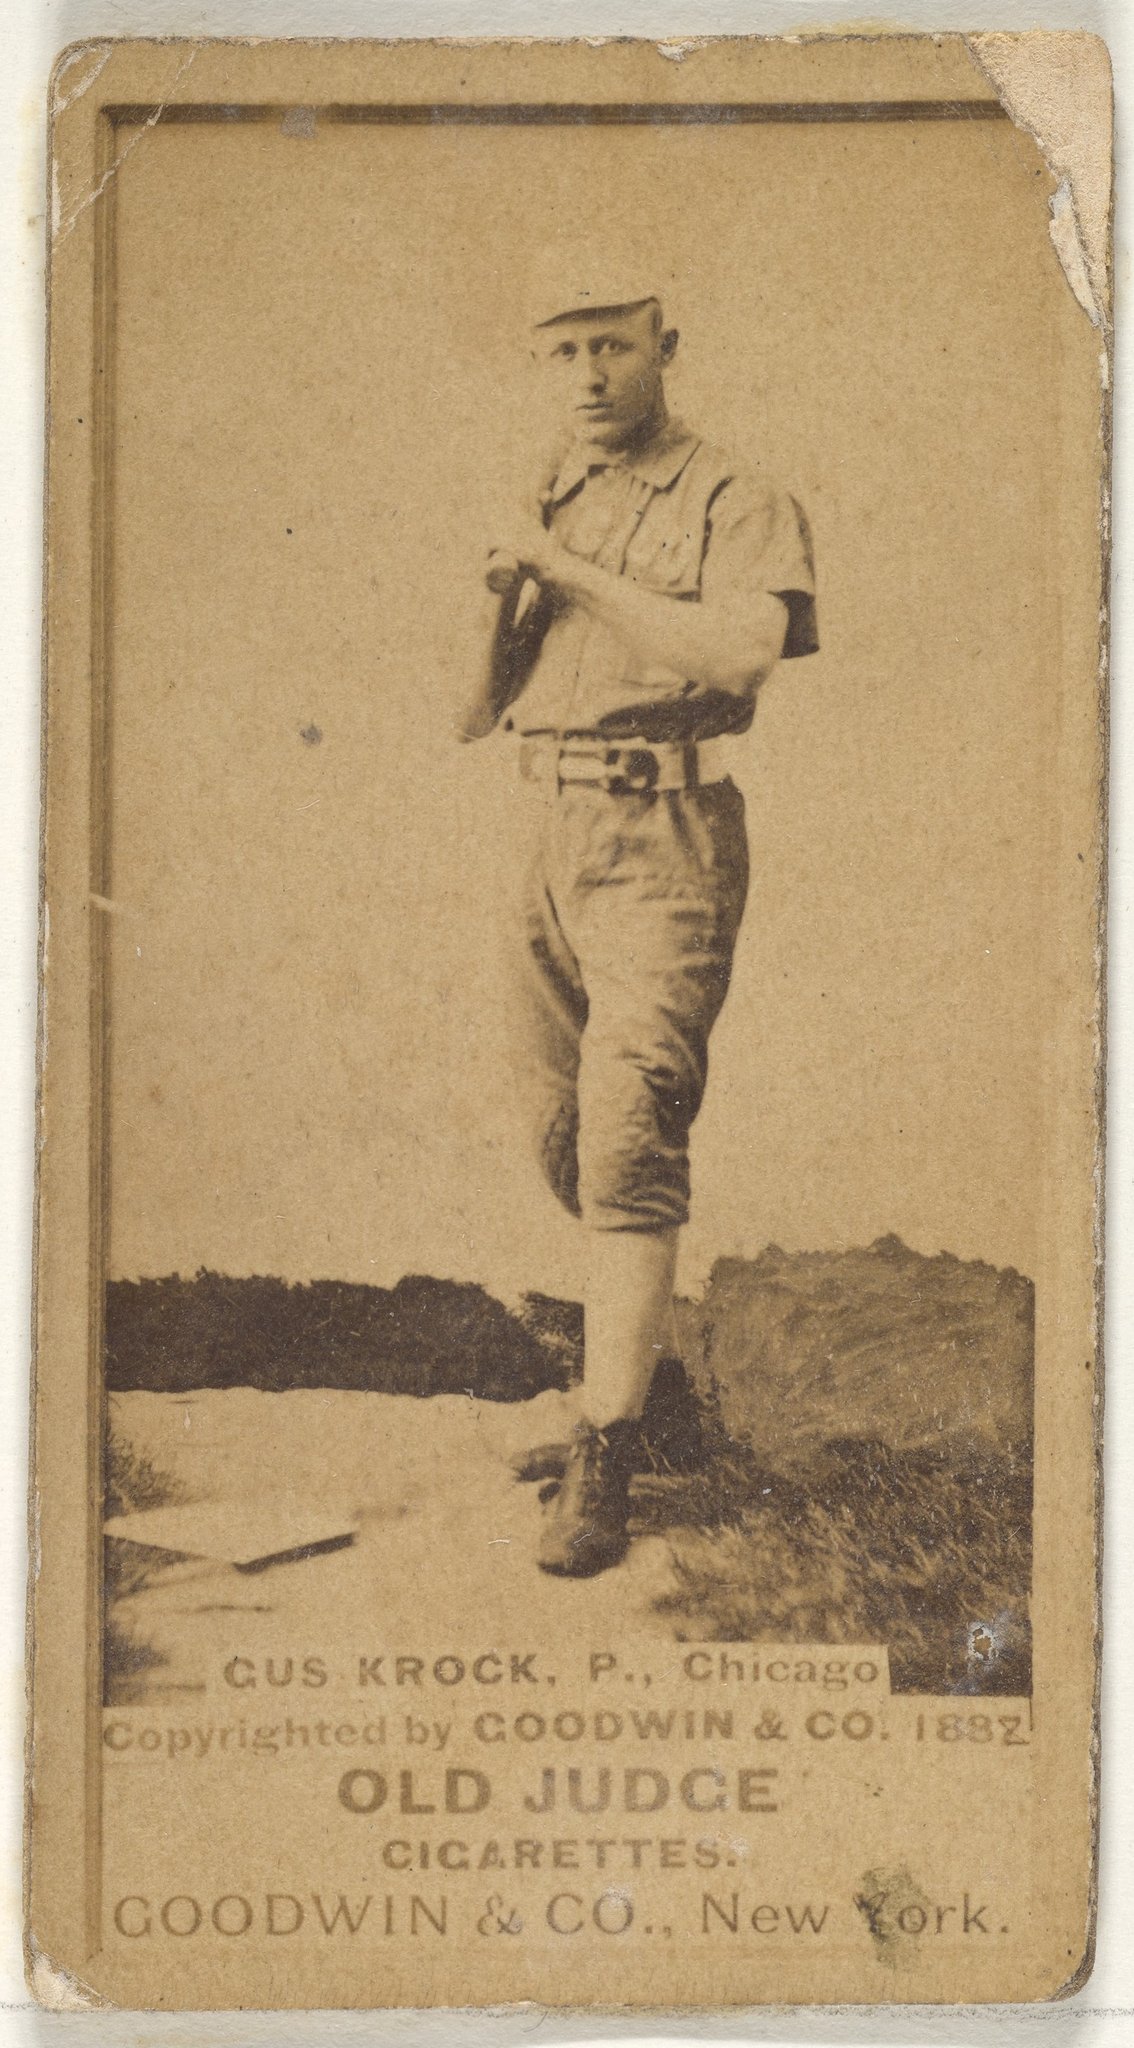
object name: baseball card, photograph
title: August H. "Gus" Krock, Pitcher, Chicago, from the Old Judge series (N172) for Old Judge Cigarettes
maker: goodwin & company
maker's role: publisher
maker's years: 1850-1950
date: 1888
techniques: albumen silver print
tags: men,portraits,baseball,athletes